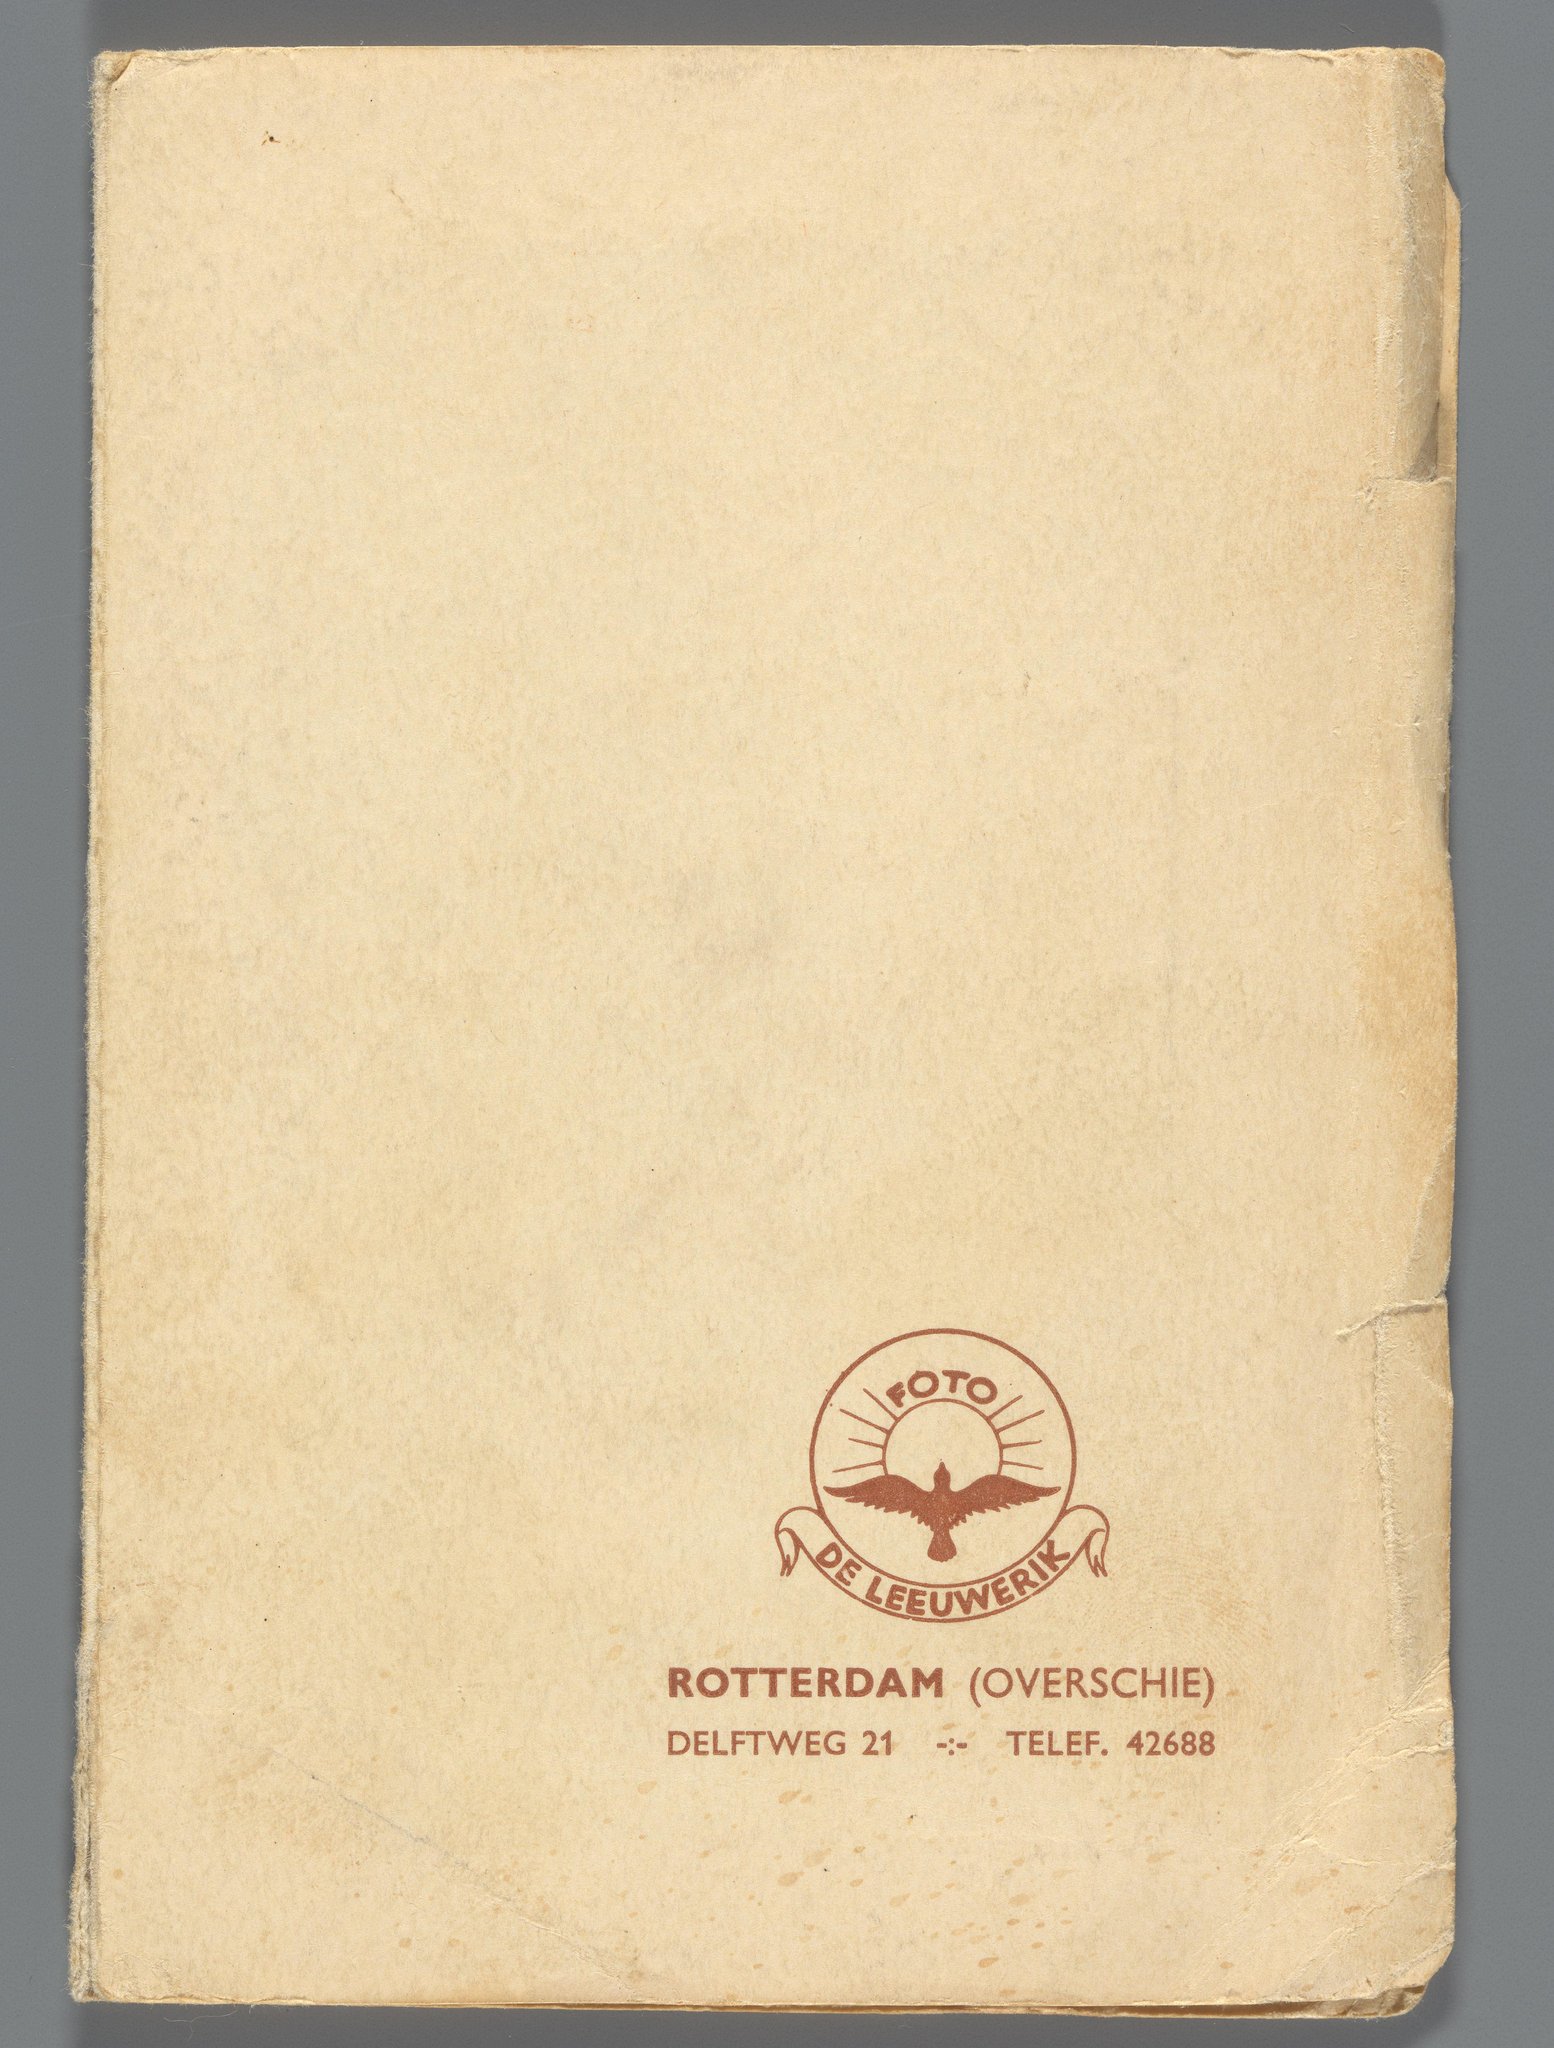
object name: accordion book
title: Leperelloalbum met foto's van een variétévoorstelling van een amateurgezelschap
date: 1950-1980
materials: paper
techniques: gelatin silver print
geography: overschie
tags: theatre, theatrical performance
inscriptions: address: ‘ROTTERDAM (OVERSCHIE)/ DELFTWEG 21 - TELEF. 42688’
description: Leperelloalbum met zes bladen en drie losse foto's.